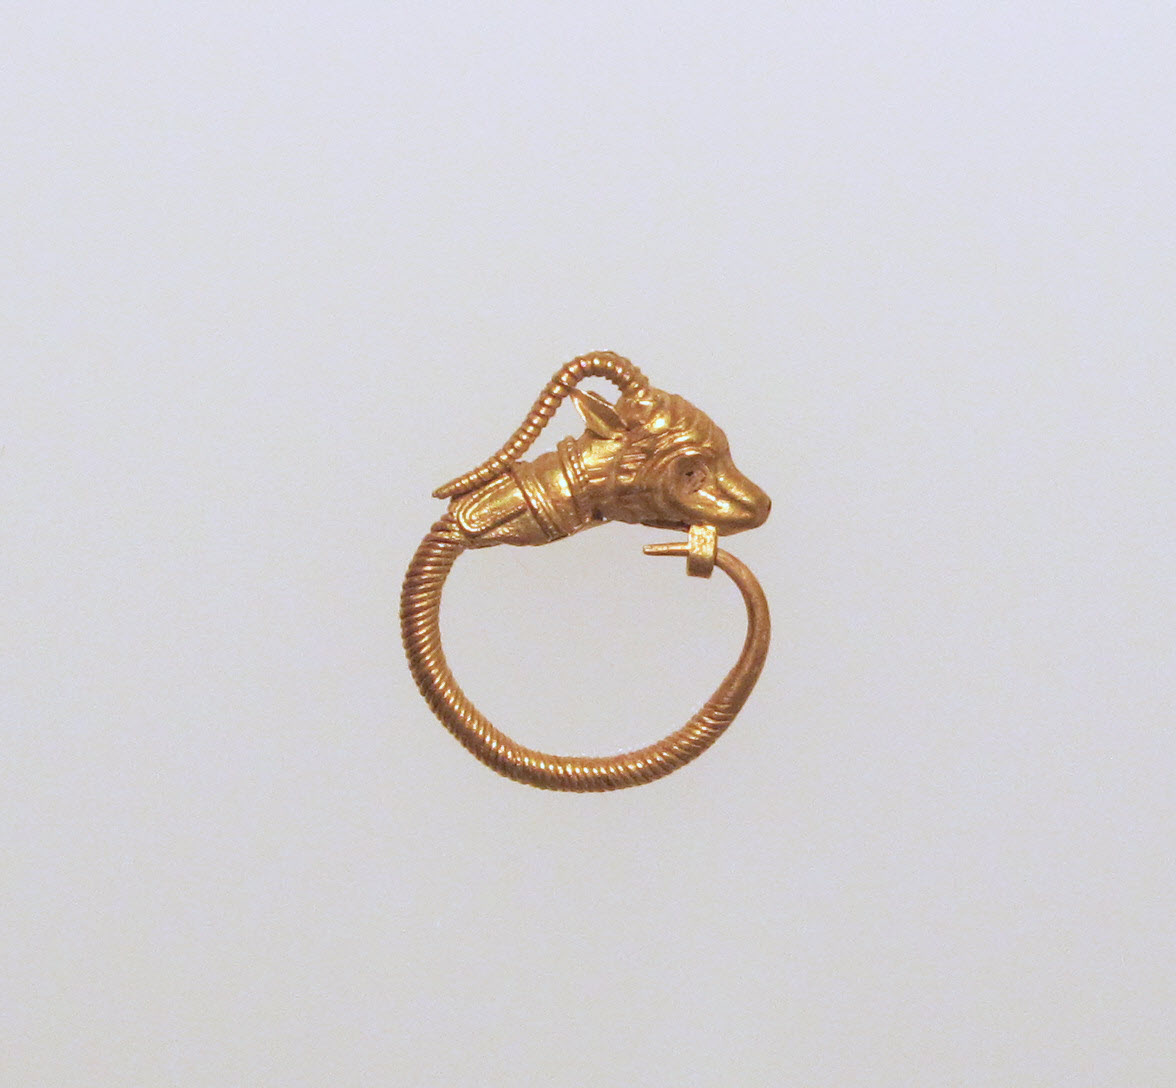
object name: earring with head of antelope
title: Gold earring with head of an antelope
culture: greek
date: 400-201 BCE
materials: gold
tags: deer